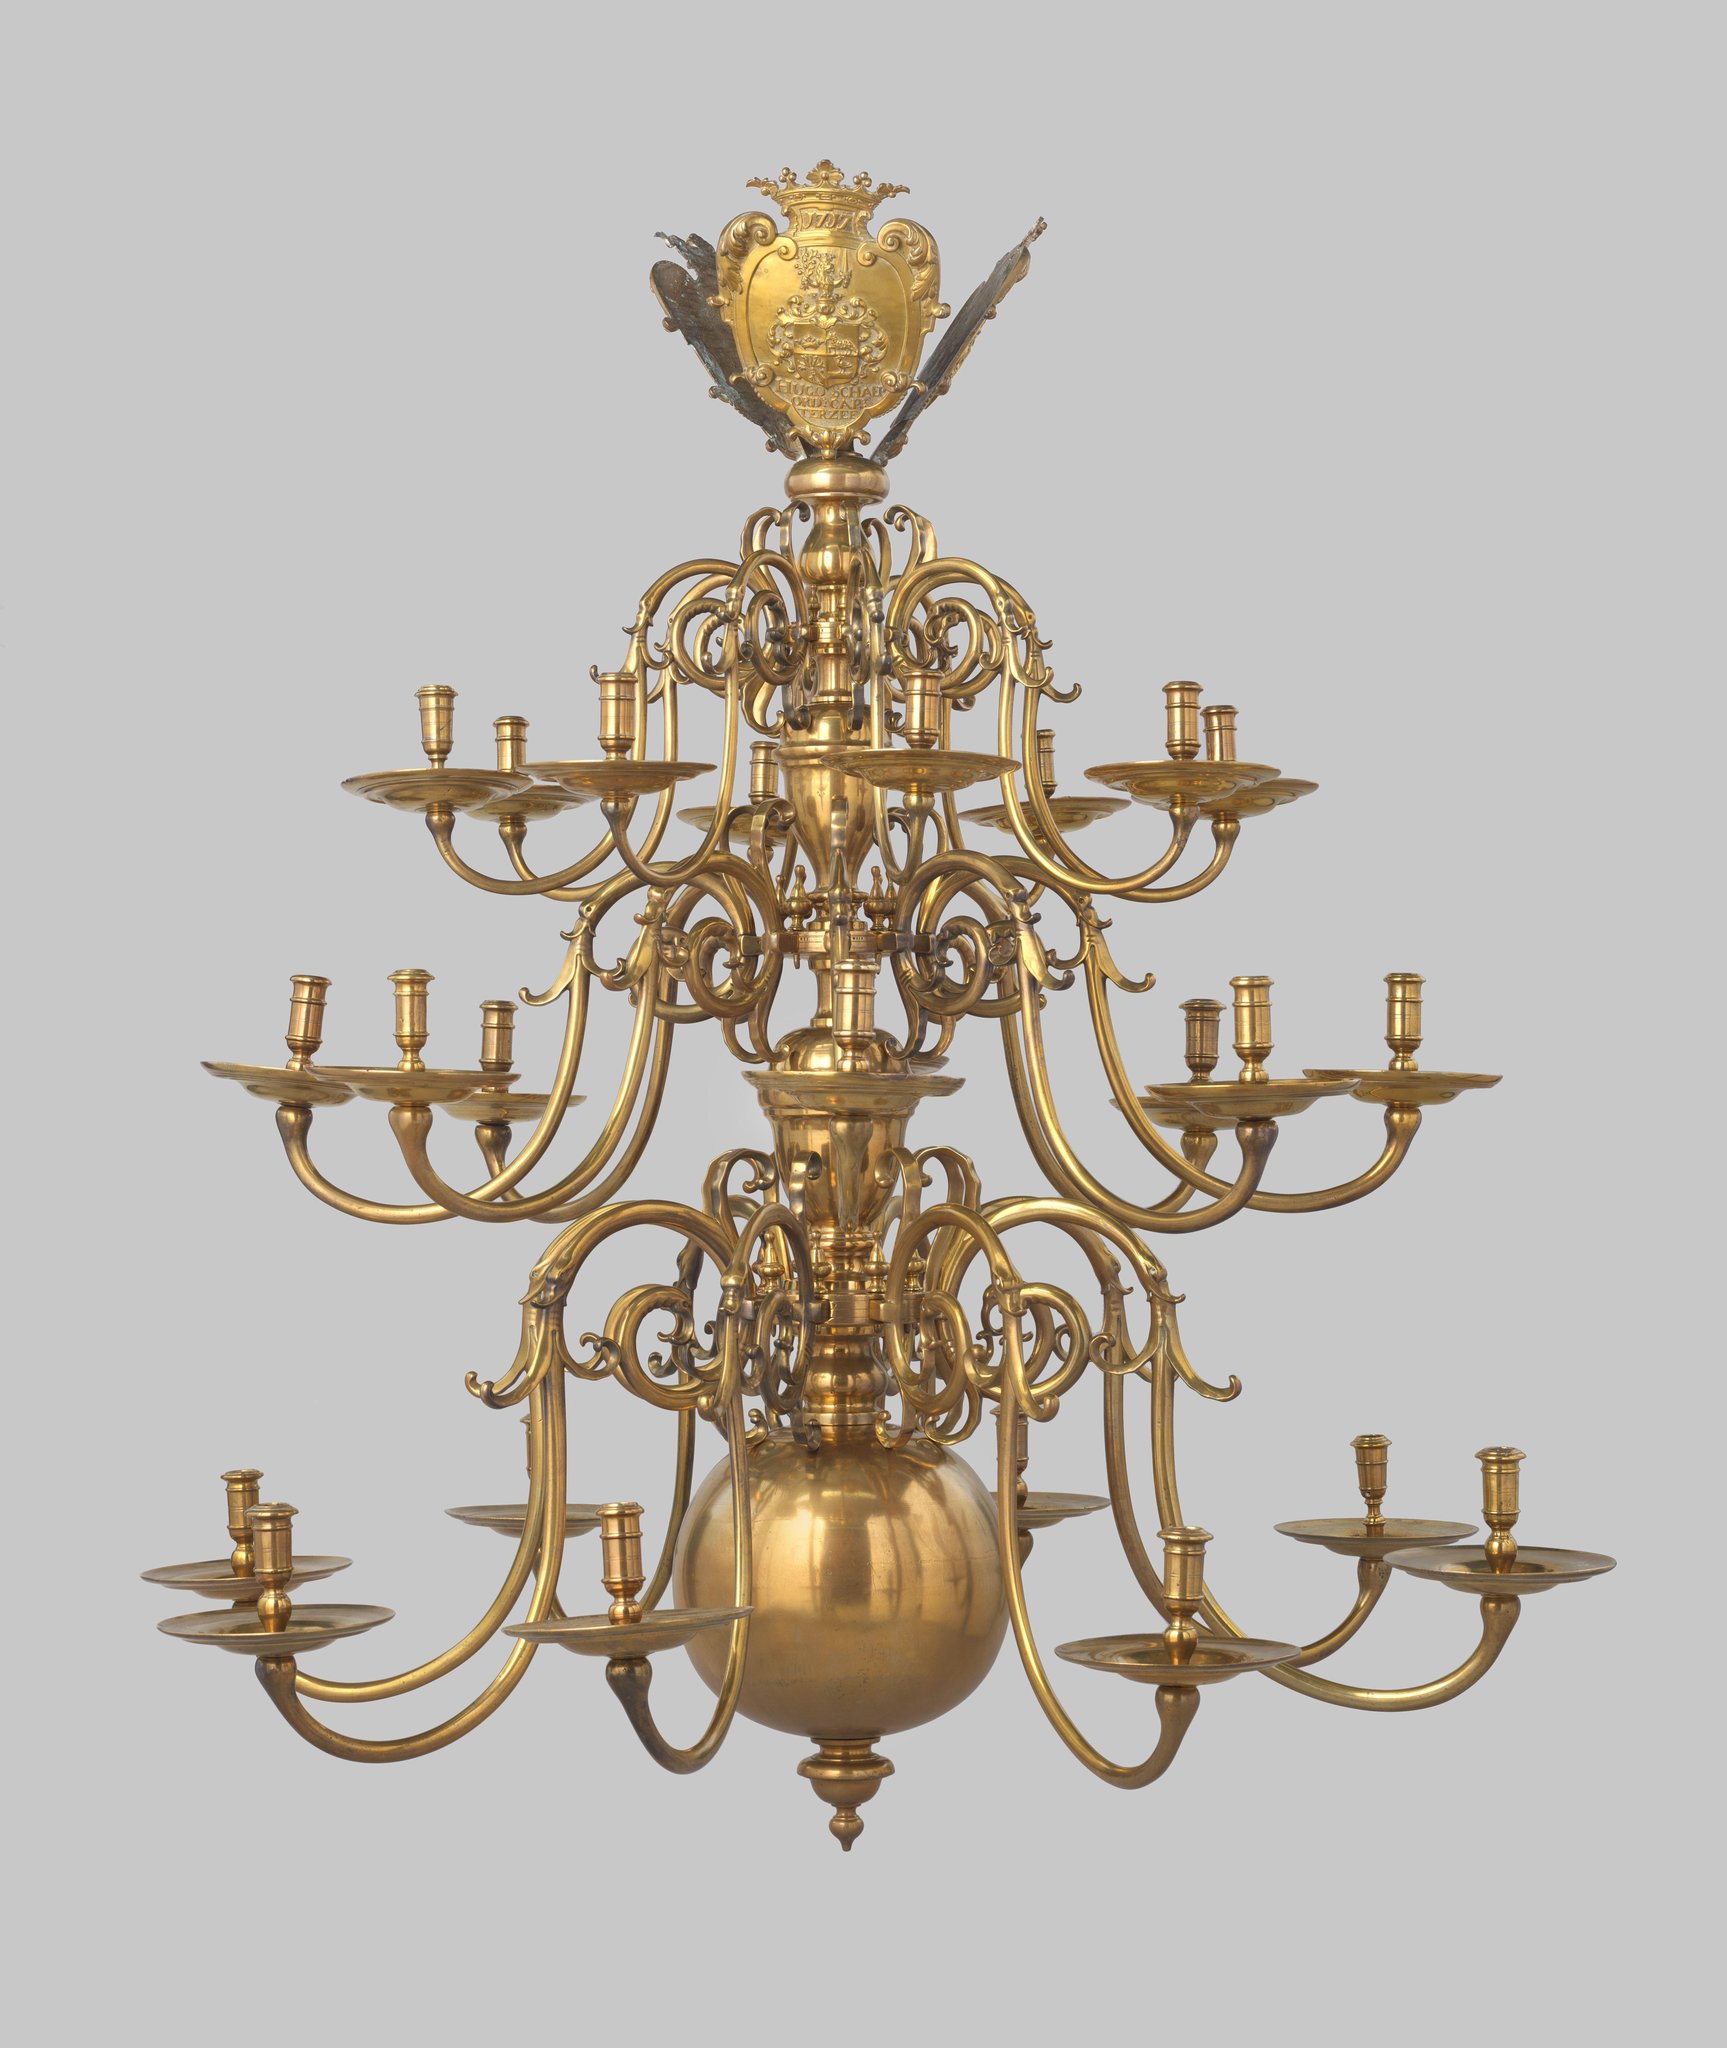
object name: chandelier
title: Arm van een kaarsenkroon in drie hoogten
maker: Anonymous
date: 1717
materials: brass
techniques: casting, screwed, turning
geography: amsterdam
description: De S-vormige arm is aan de stamzijde voorzien van een nok om deze met een pin in de standring te kunnen vastzetten. Bij de stam is de arm op het eind en naar het midden toe versierd met twee gestileerde dolfijnenkoppen en met krullen, waarvan de vorm aan het kwabornament is ontleend. Naar buiten toe eindigt de arm in een verdikking, waarin een van een schroefdraad voorzien gat is aangebracht ter bevestiging van de kaarsenhouder op de vetvanger. De arm is met behulp van hetzelfde model gegoten als de overige armen van de krans. De kaarsenhouder is cylindervormig met geprofileerd uitstekende rand en met een balustervoet, welke overgaat in een van een schroefdraad voorzien eind, waarin onderaan het centergat. De vetvanger is aan de bovenkant naar het midden toe twee keer verdiept. Aan de onderkant is deze rond het gat in het enigszins bolvormige midden geprofileerd en is de rand geribd. De vetvanger met behulp van hetzelfde model gegoten als de overige vetvangers van deze krans. De pin is voorzien van een vaasvormige knop. Dit is de zesde arm van de middelste standring, genummerd op de nok met het cijfer VI.